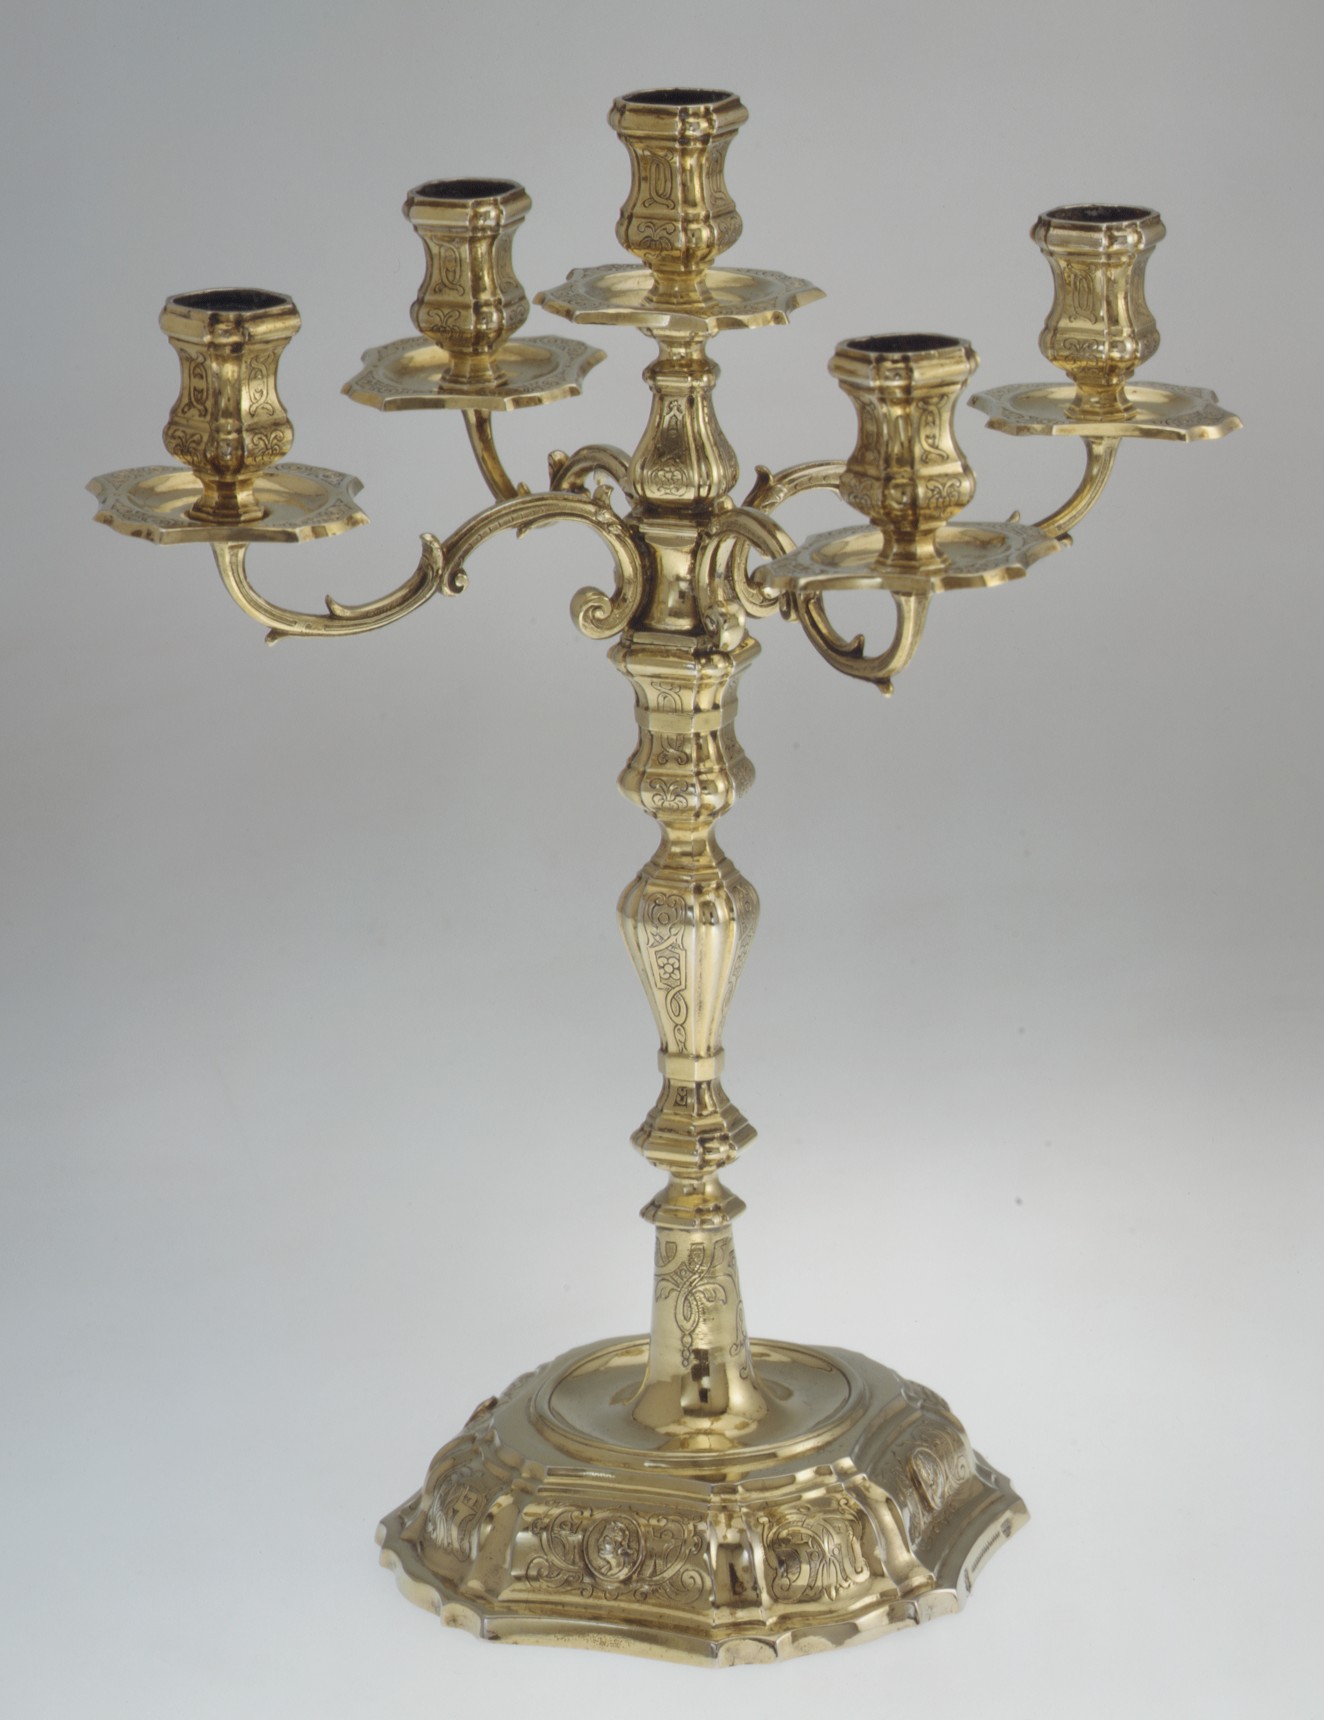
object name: candelabrum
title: Candelabrum (one of a pair)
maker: daniel friedrich metius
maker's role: maker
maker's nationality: german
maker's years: 1696-1770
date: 1726-1750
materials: silver gilt